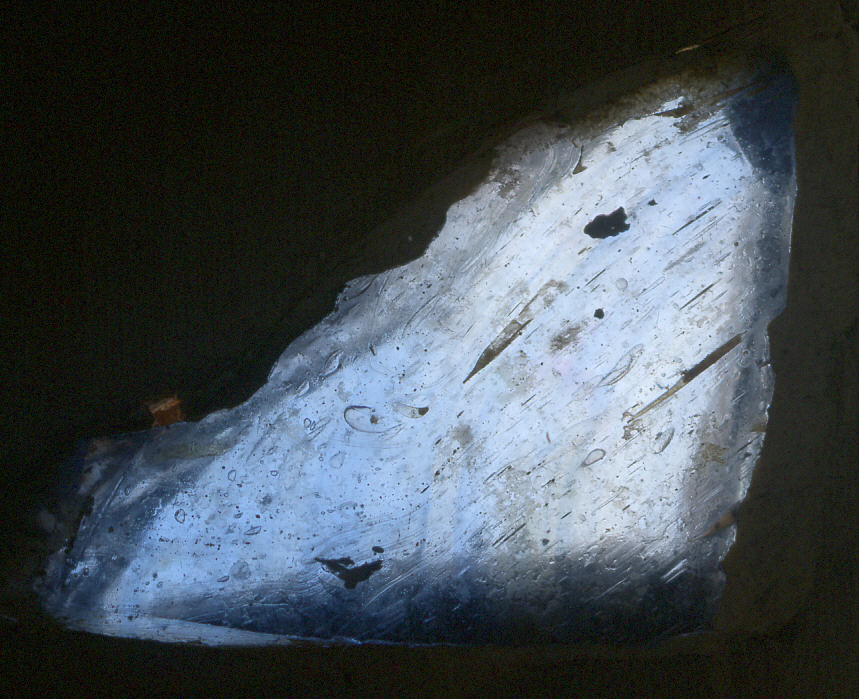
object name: fragment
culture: crusader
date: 1201-1300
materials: glass